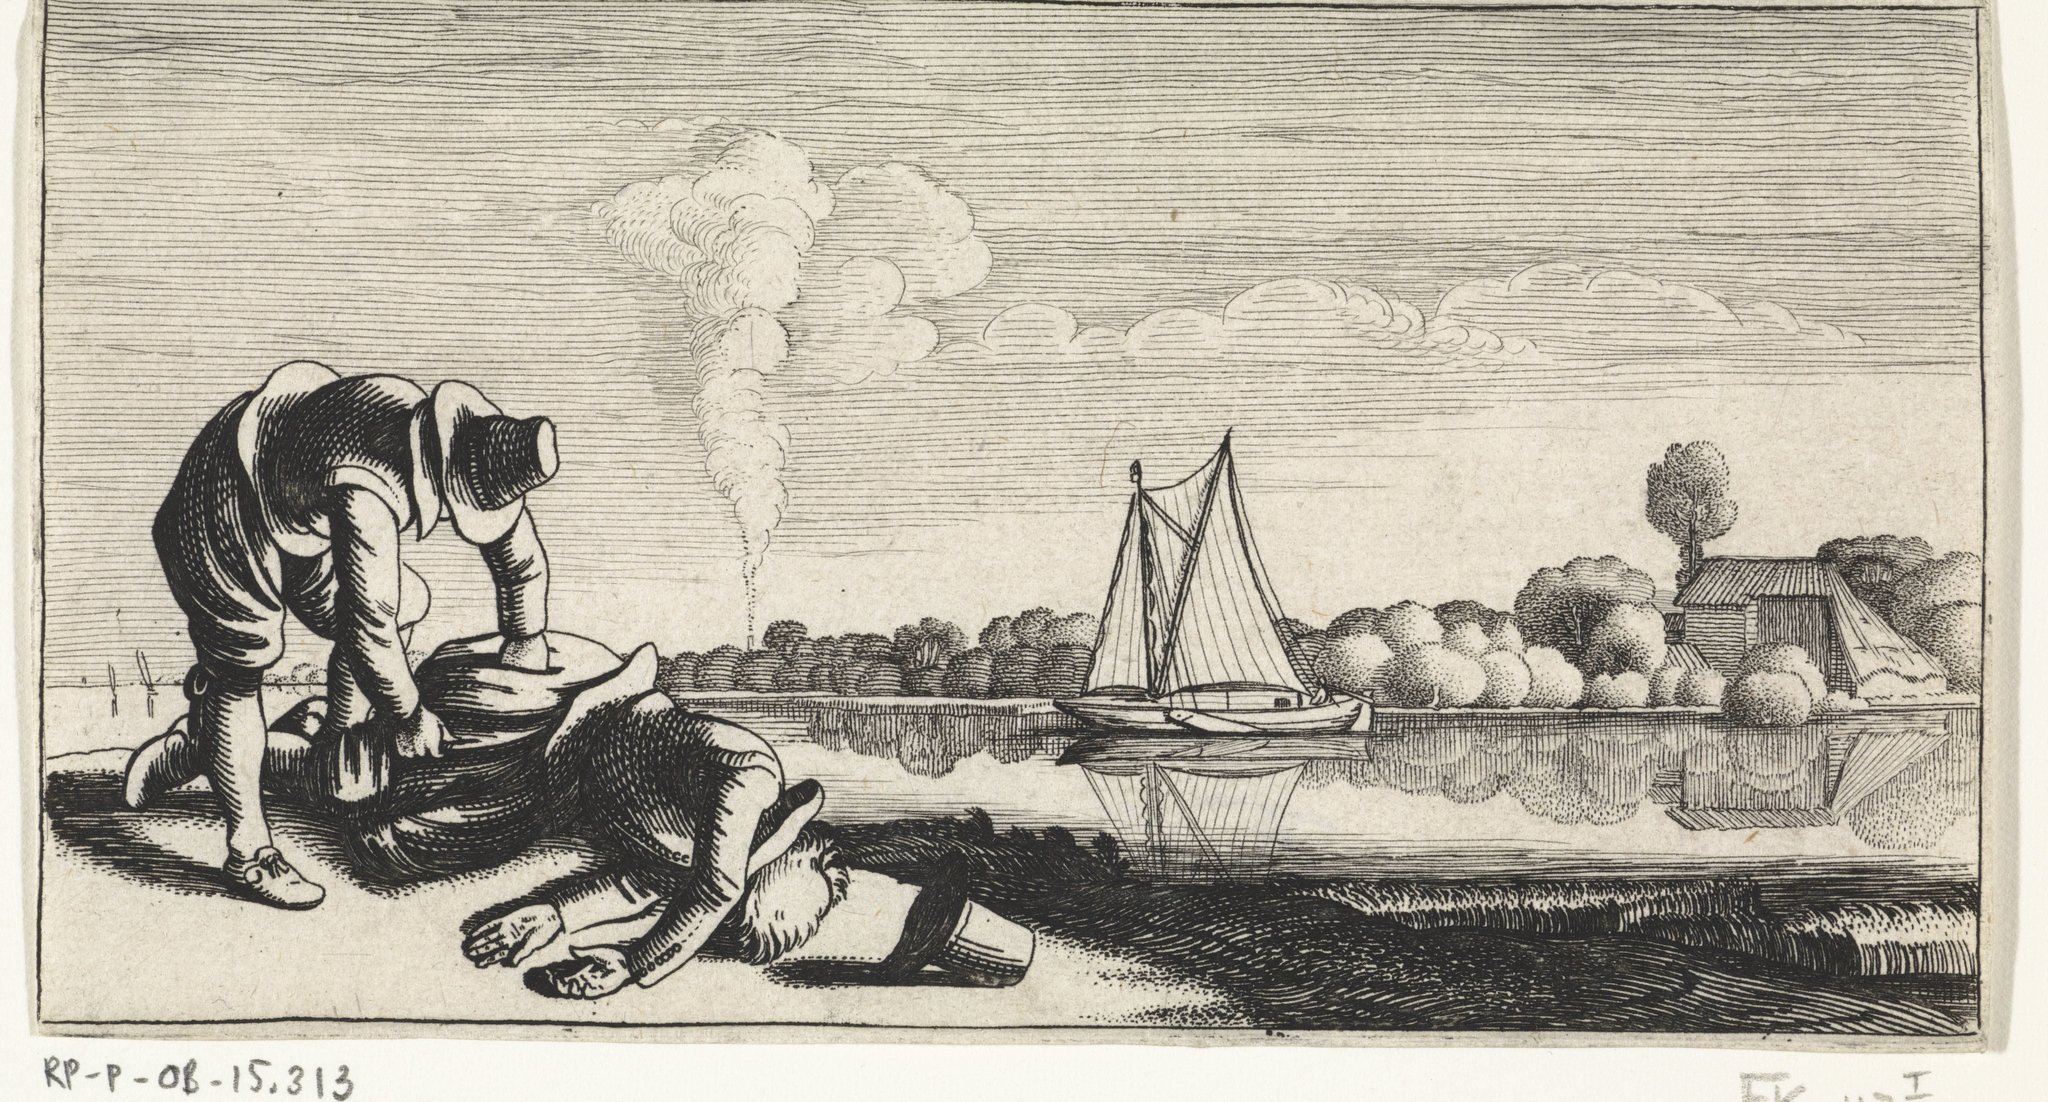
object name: print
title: Rivierlandschap met een dode die beroofd wordt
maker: jan van de velde (ii)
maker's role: draughtsman, painter, print maker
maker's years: 1593-1641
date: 1603-1641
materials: paper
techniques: engraving, etching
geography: northern netherlands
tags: smoke-stack, river, robber, the corpse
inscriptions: collector's mark: Lugt 240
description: Een dode op de oever van een rivier wordt beroofd. Op de rivier een zeilschip en aan de horizon een rookpluim. Tweede prent uit een serie van zes.